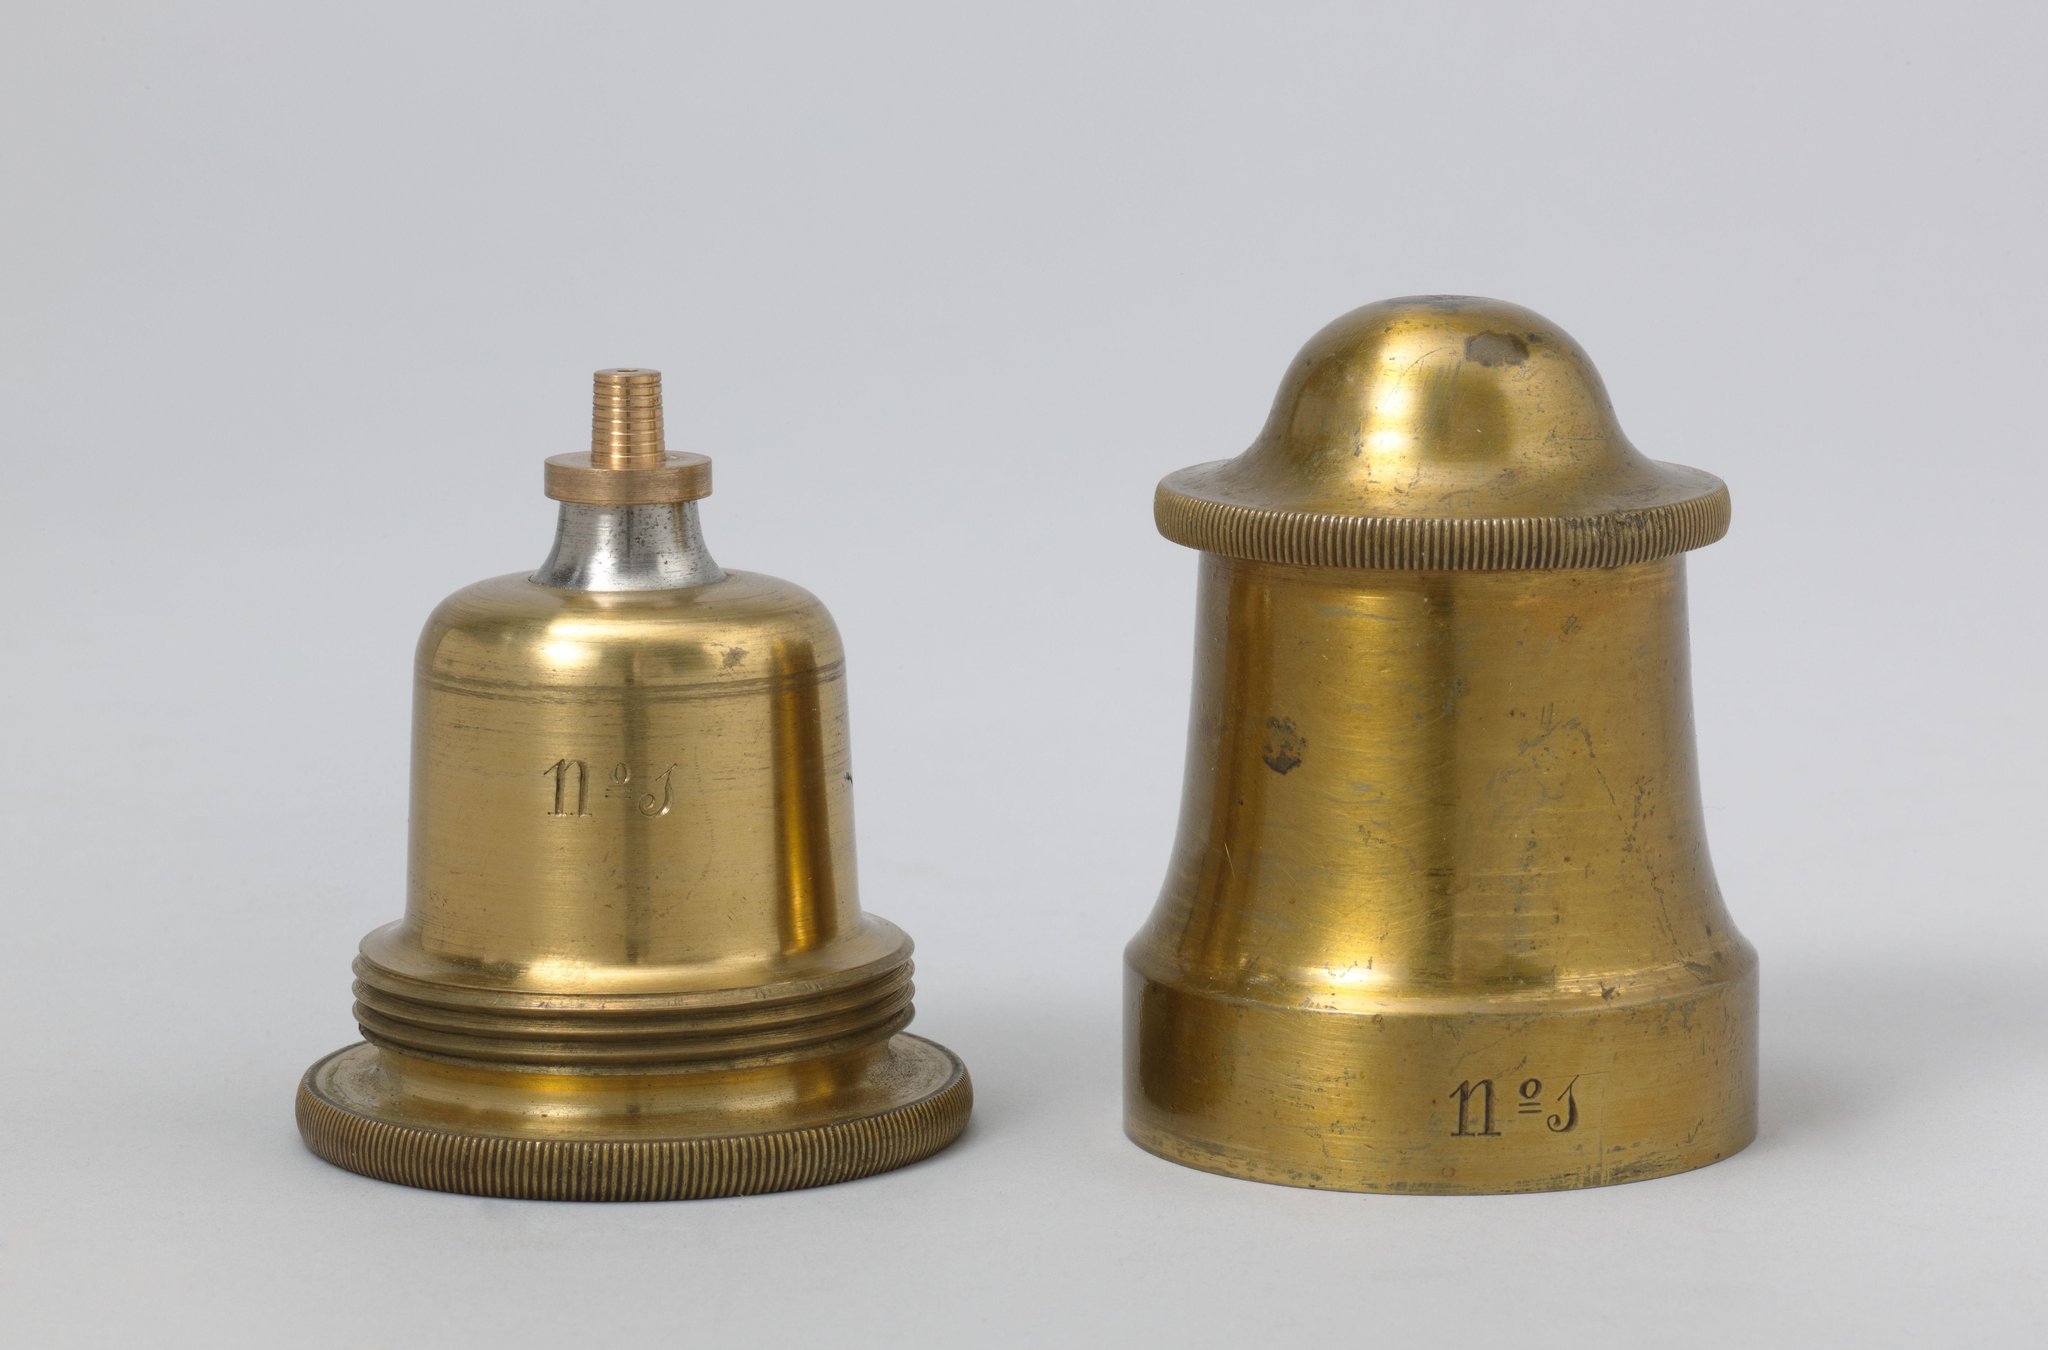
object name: test model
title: Gauge for Priming Tubes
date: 1860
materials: brass, copper, iron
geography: netherlands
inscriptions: inscription, on both parts: ‘Nº 1’, inscription, on the rim of the cover: ‘SVD / 1860’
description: Deze mal werd gebruikt om te bepalen of het saskanaal van het slagpijpje exact in het midden geboord was. Het preciese gebruik is nog niet achterhaald.